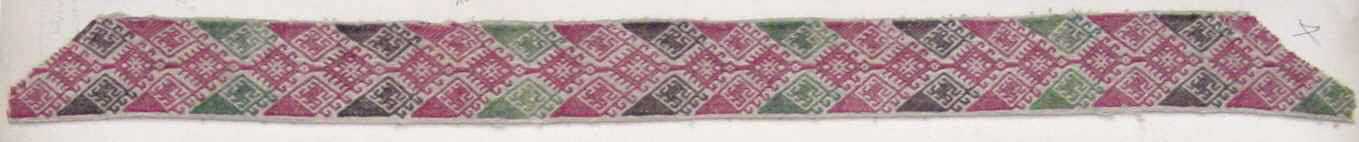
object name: textile fragment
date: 1701-1800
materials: linen, silk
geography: turkey